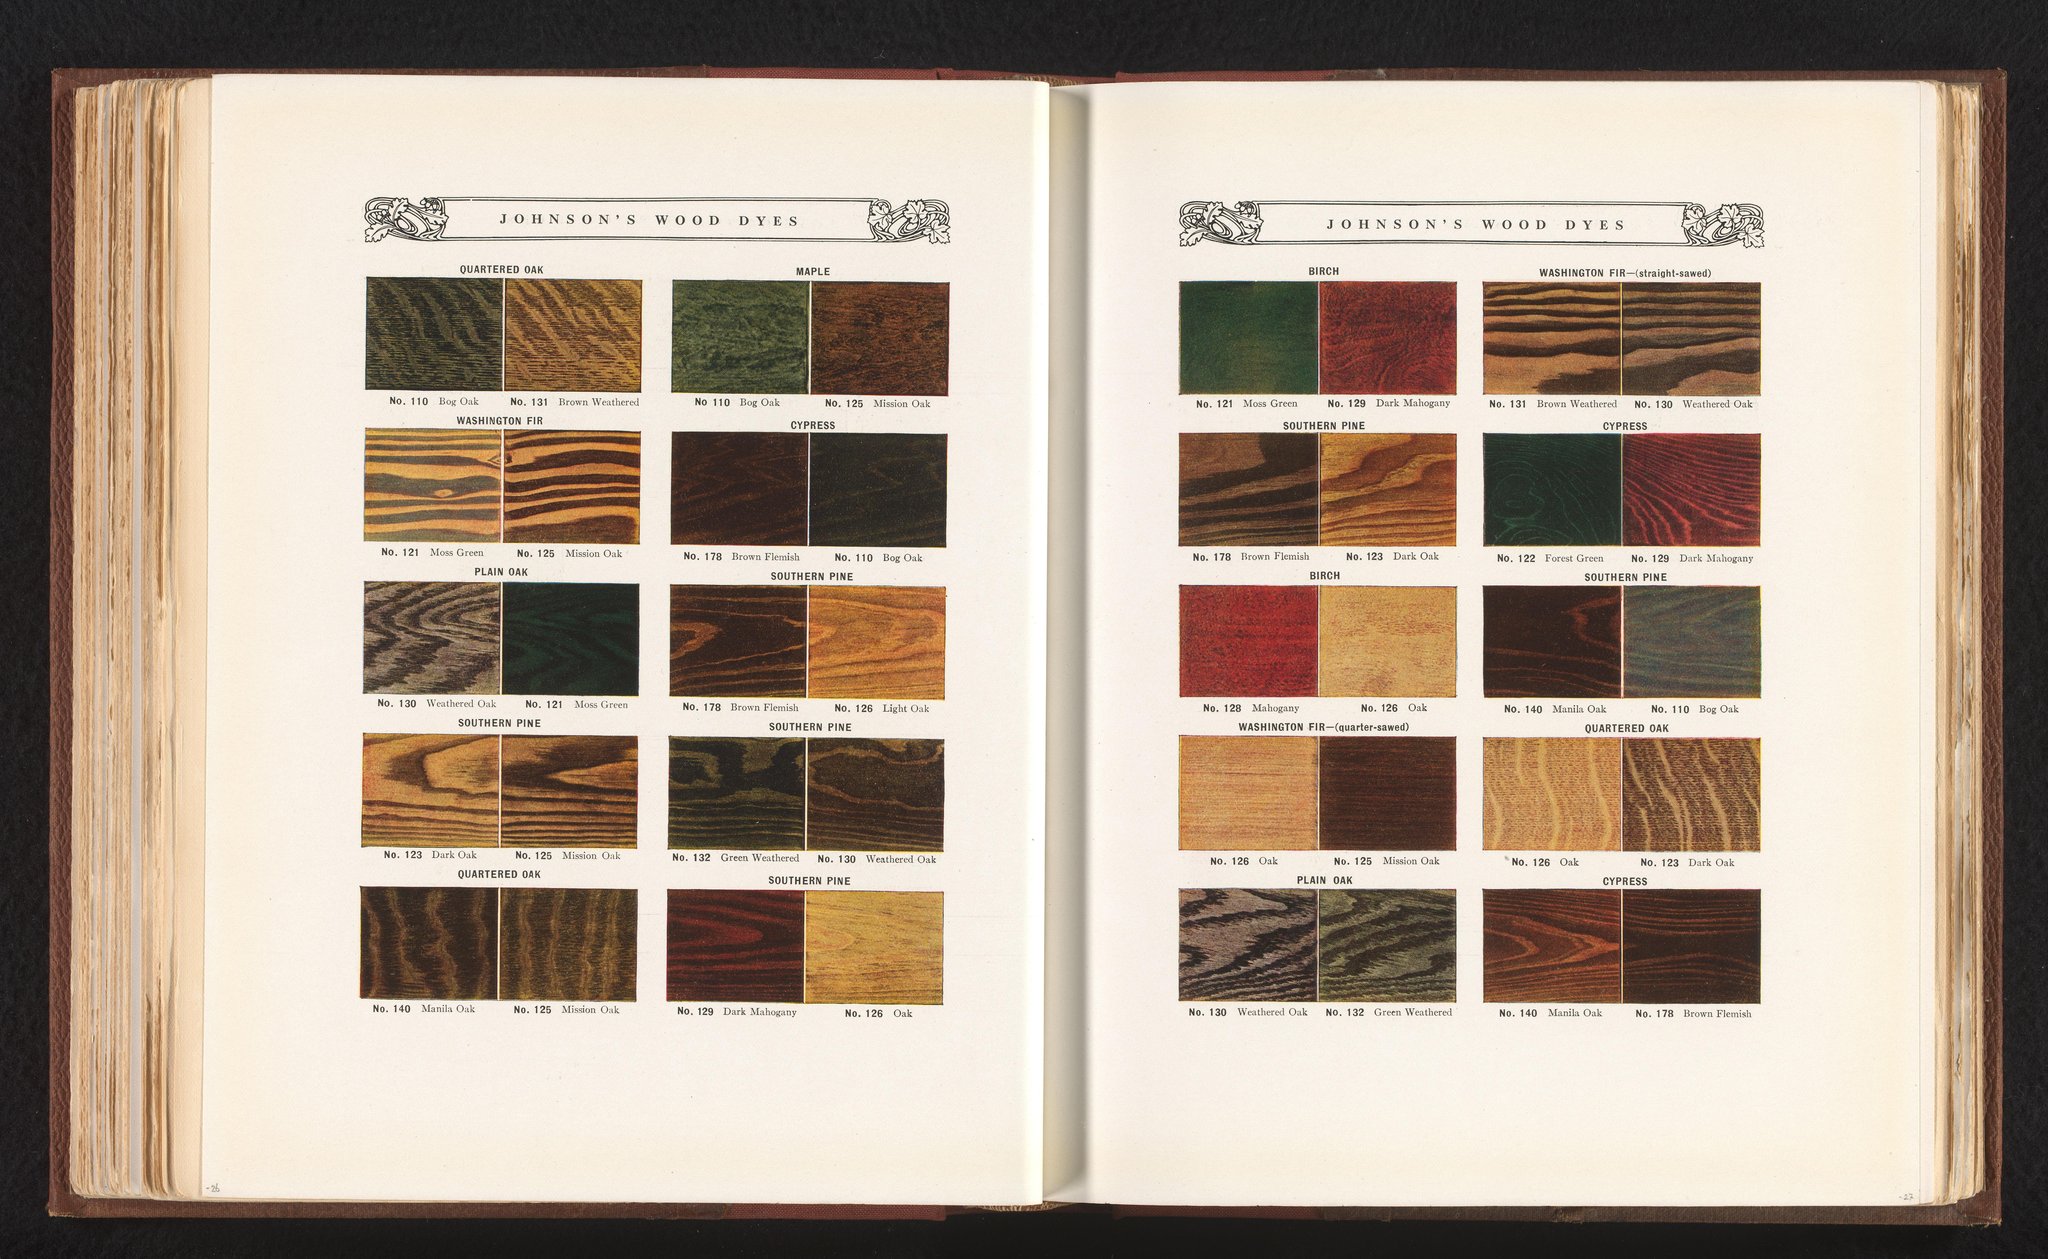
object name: page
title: Reclame voor Johnson's houtverf, uit de catalogus 'Proper Treatment of Floor, Woodwork and Furniture' gepubliceerd door S.C. Johnson & Son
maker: Anonymous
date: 1904-1909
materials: paper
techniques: three-color autotype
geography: milwaukee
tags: wood, timber ~ building material, colours, pigments, and paints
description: Prent op derde ongenummerde pagina na pagina 201.